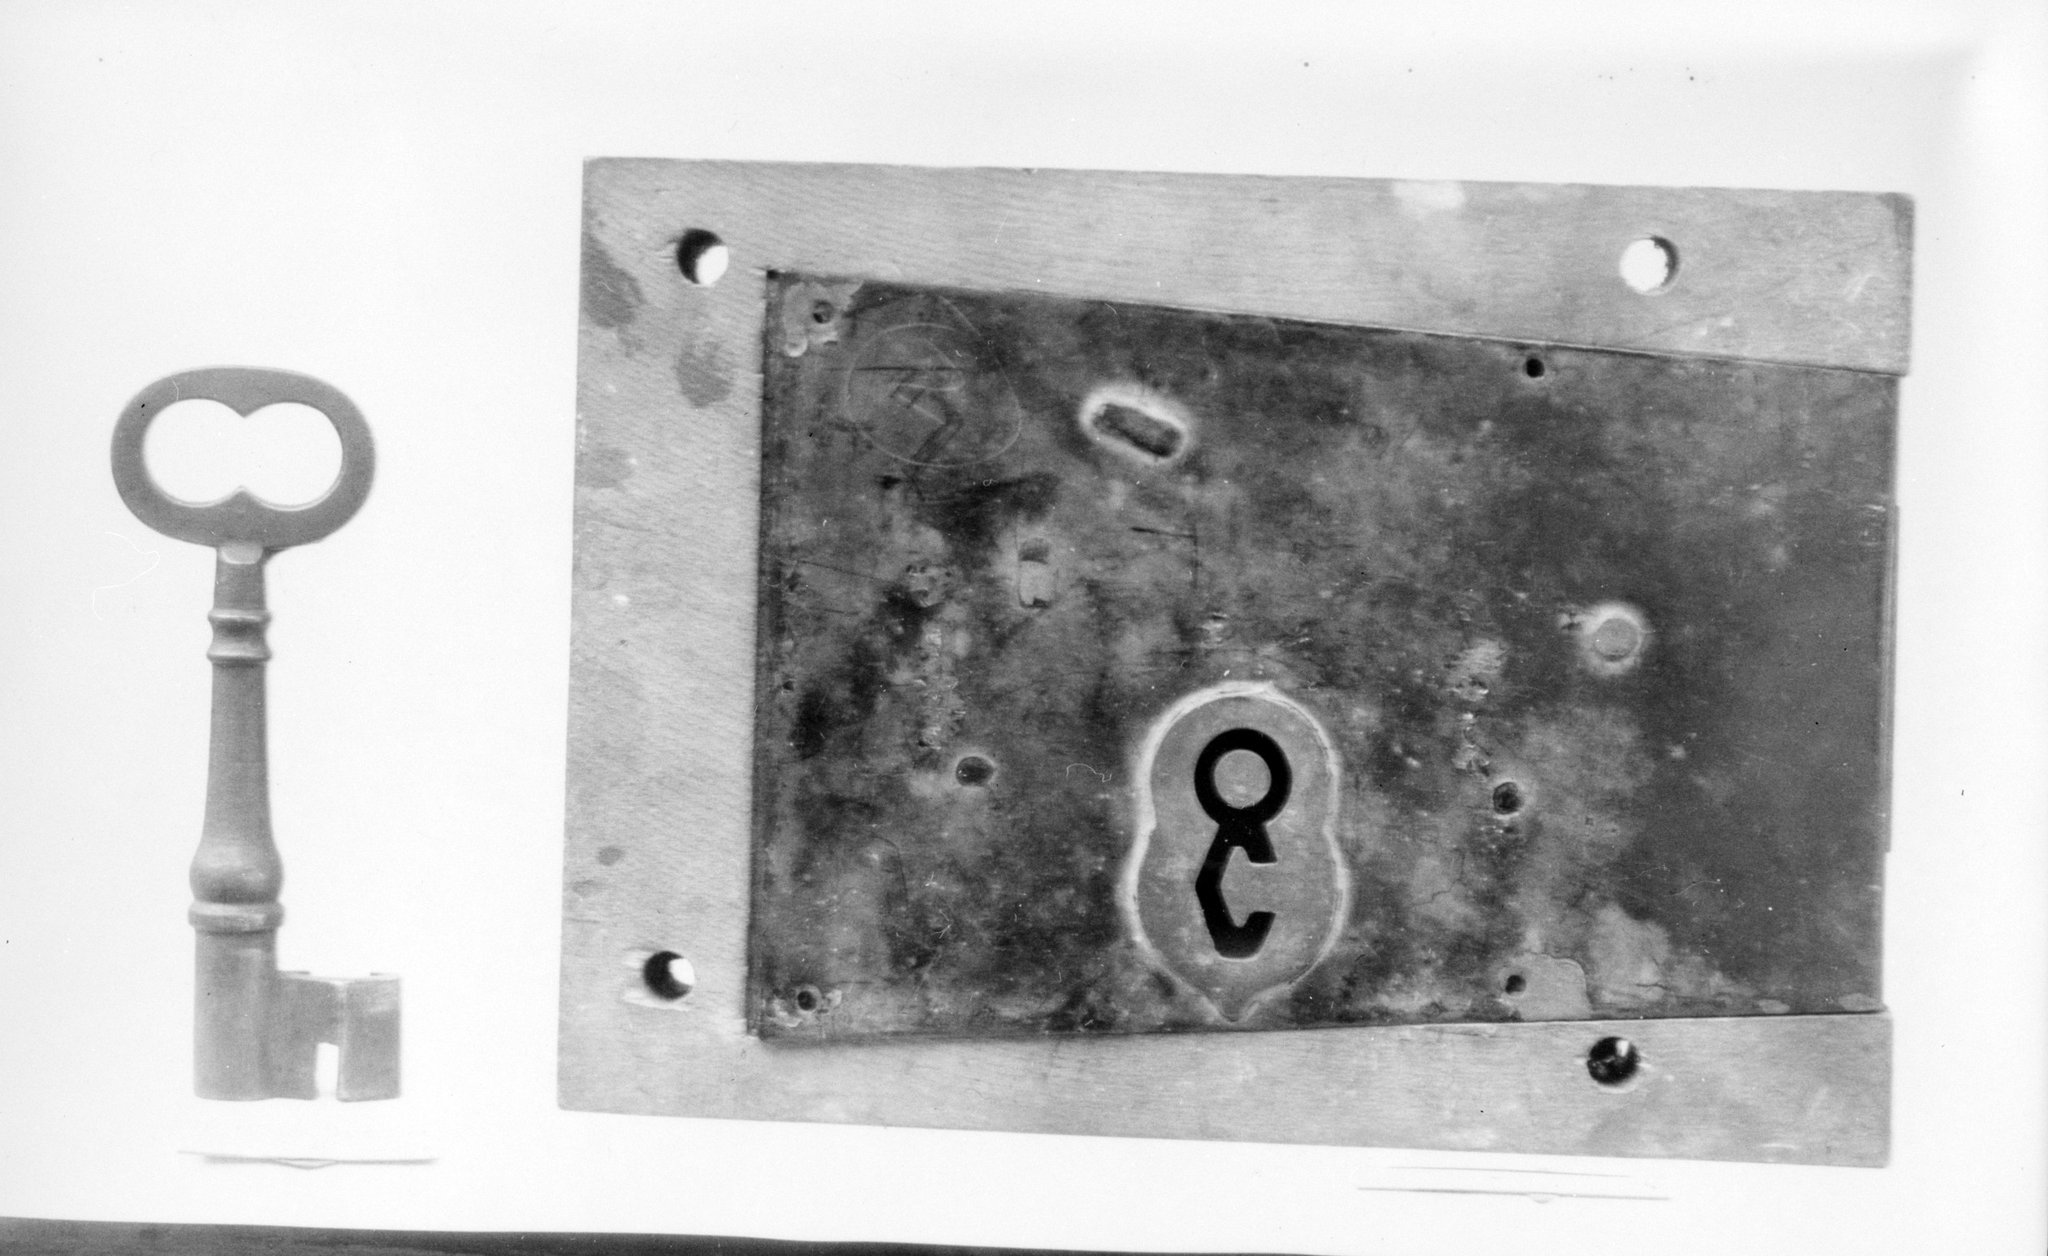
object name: lock and key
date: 1700-1730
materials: iron, wood